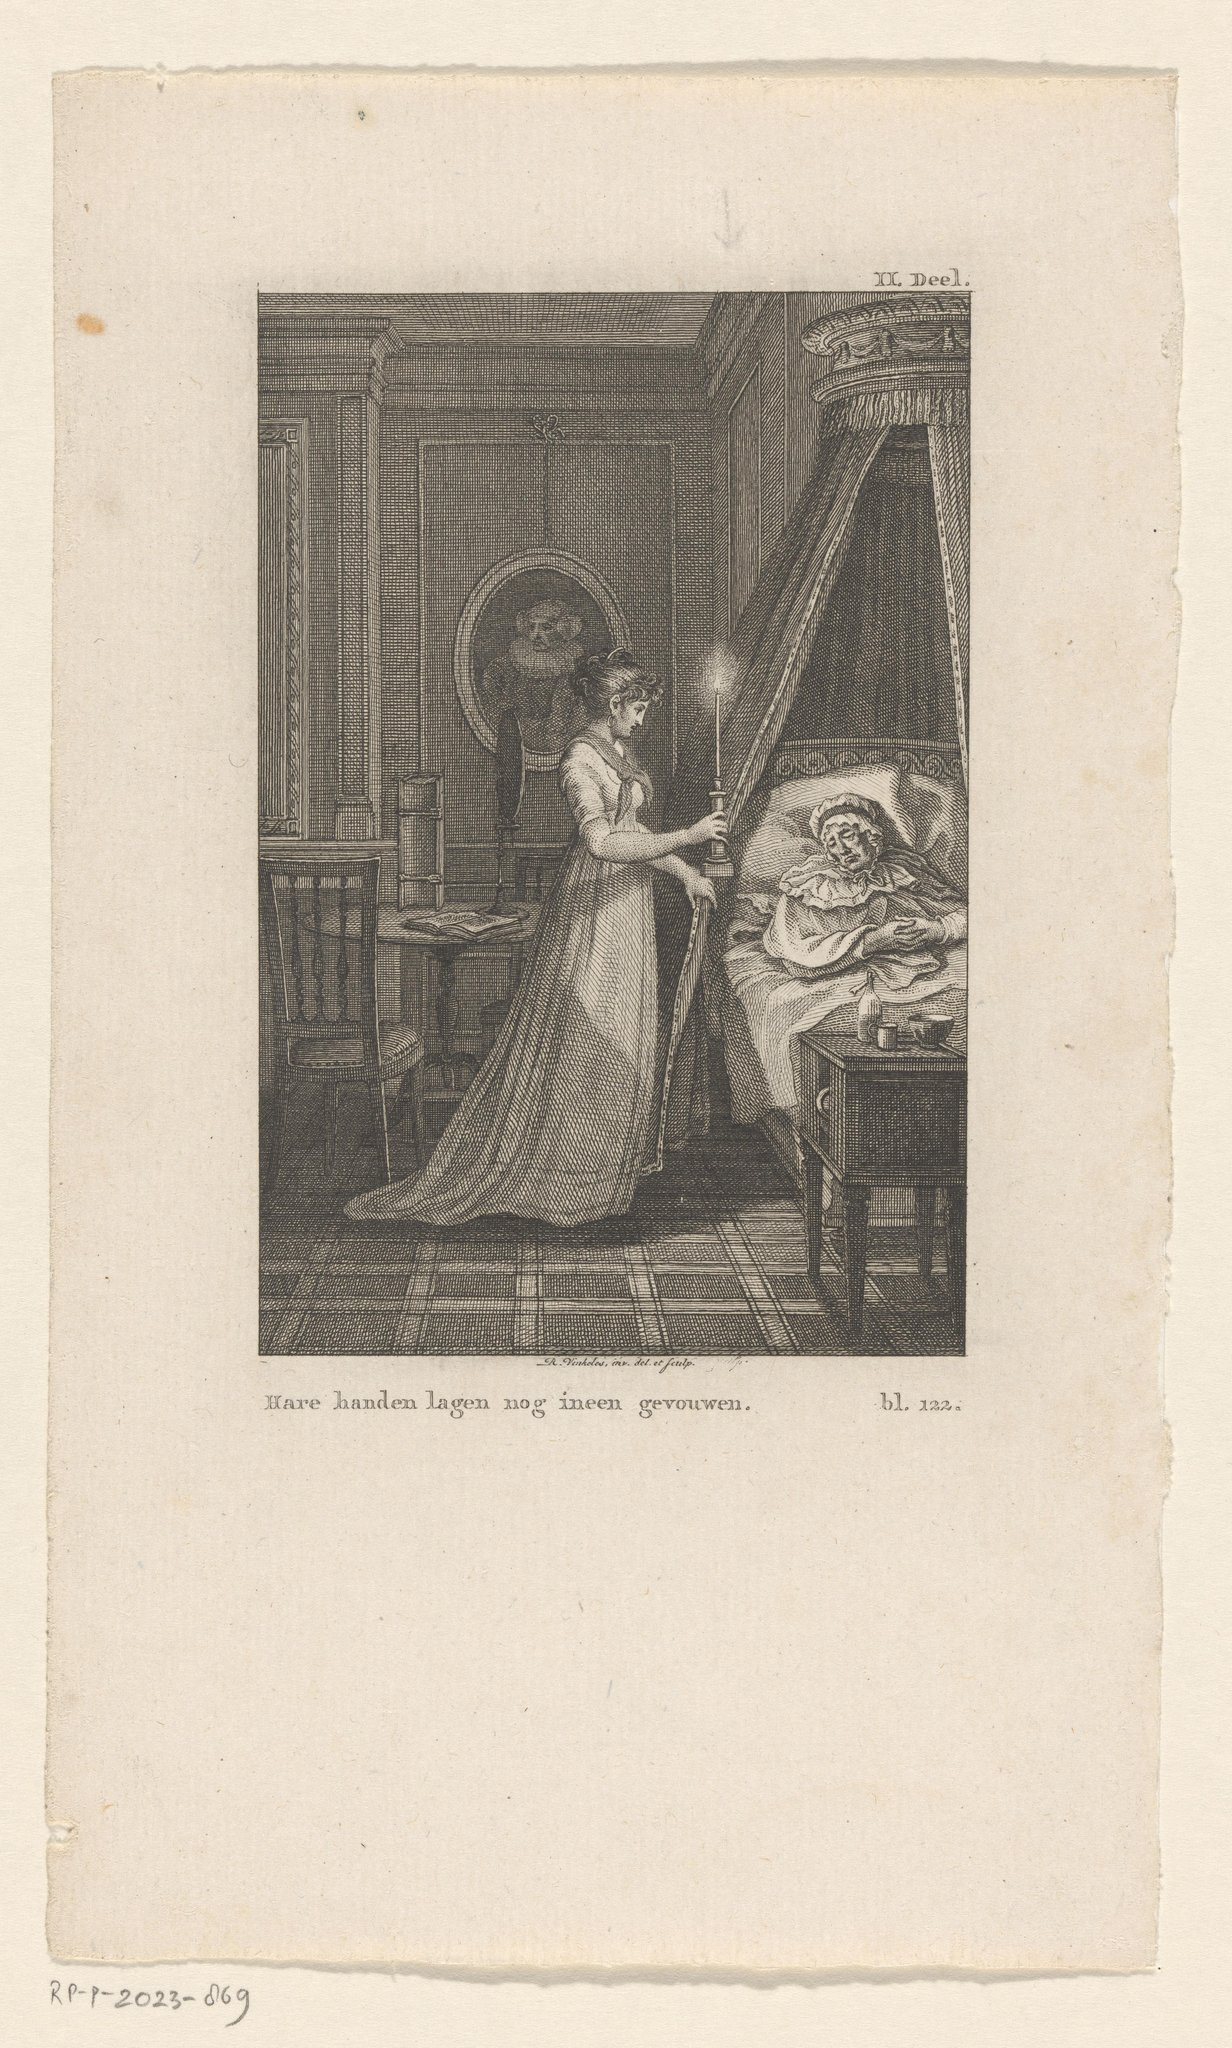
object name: print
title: Susanna Bronkhorst bij het sterfbed van mevrouw Elzevier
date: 1806-1807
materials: paper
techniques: engraving, etching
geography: haarlem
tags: bed with tester, deathbed, candle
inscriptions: collector's mark: Lugt 2228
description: In een donkere kamer staat een meisje met een kaars bij een oude vrouw, liggend in bed. Zij heeft haar ogen gesloten en haar handen gevouwen. Onder de prent de tekst: Hare handen lagen nog ineen gevouwen.